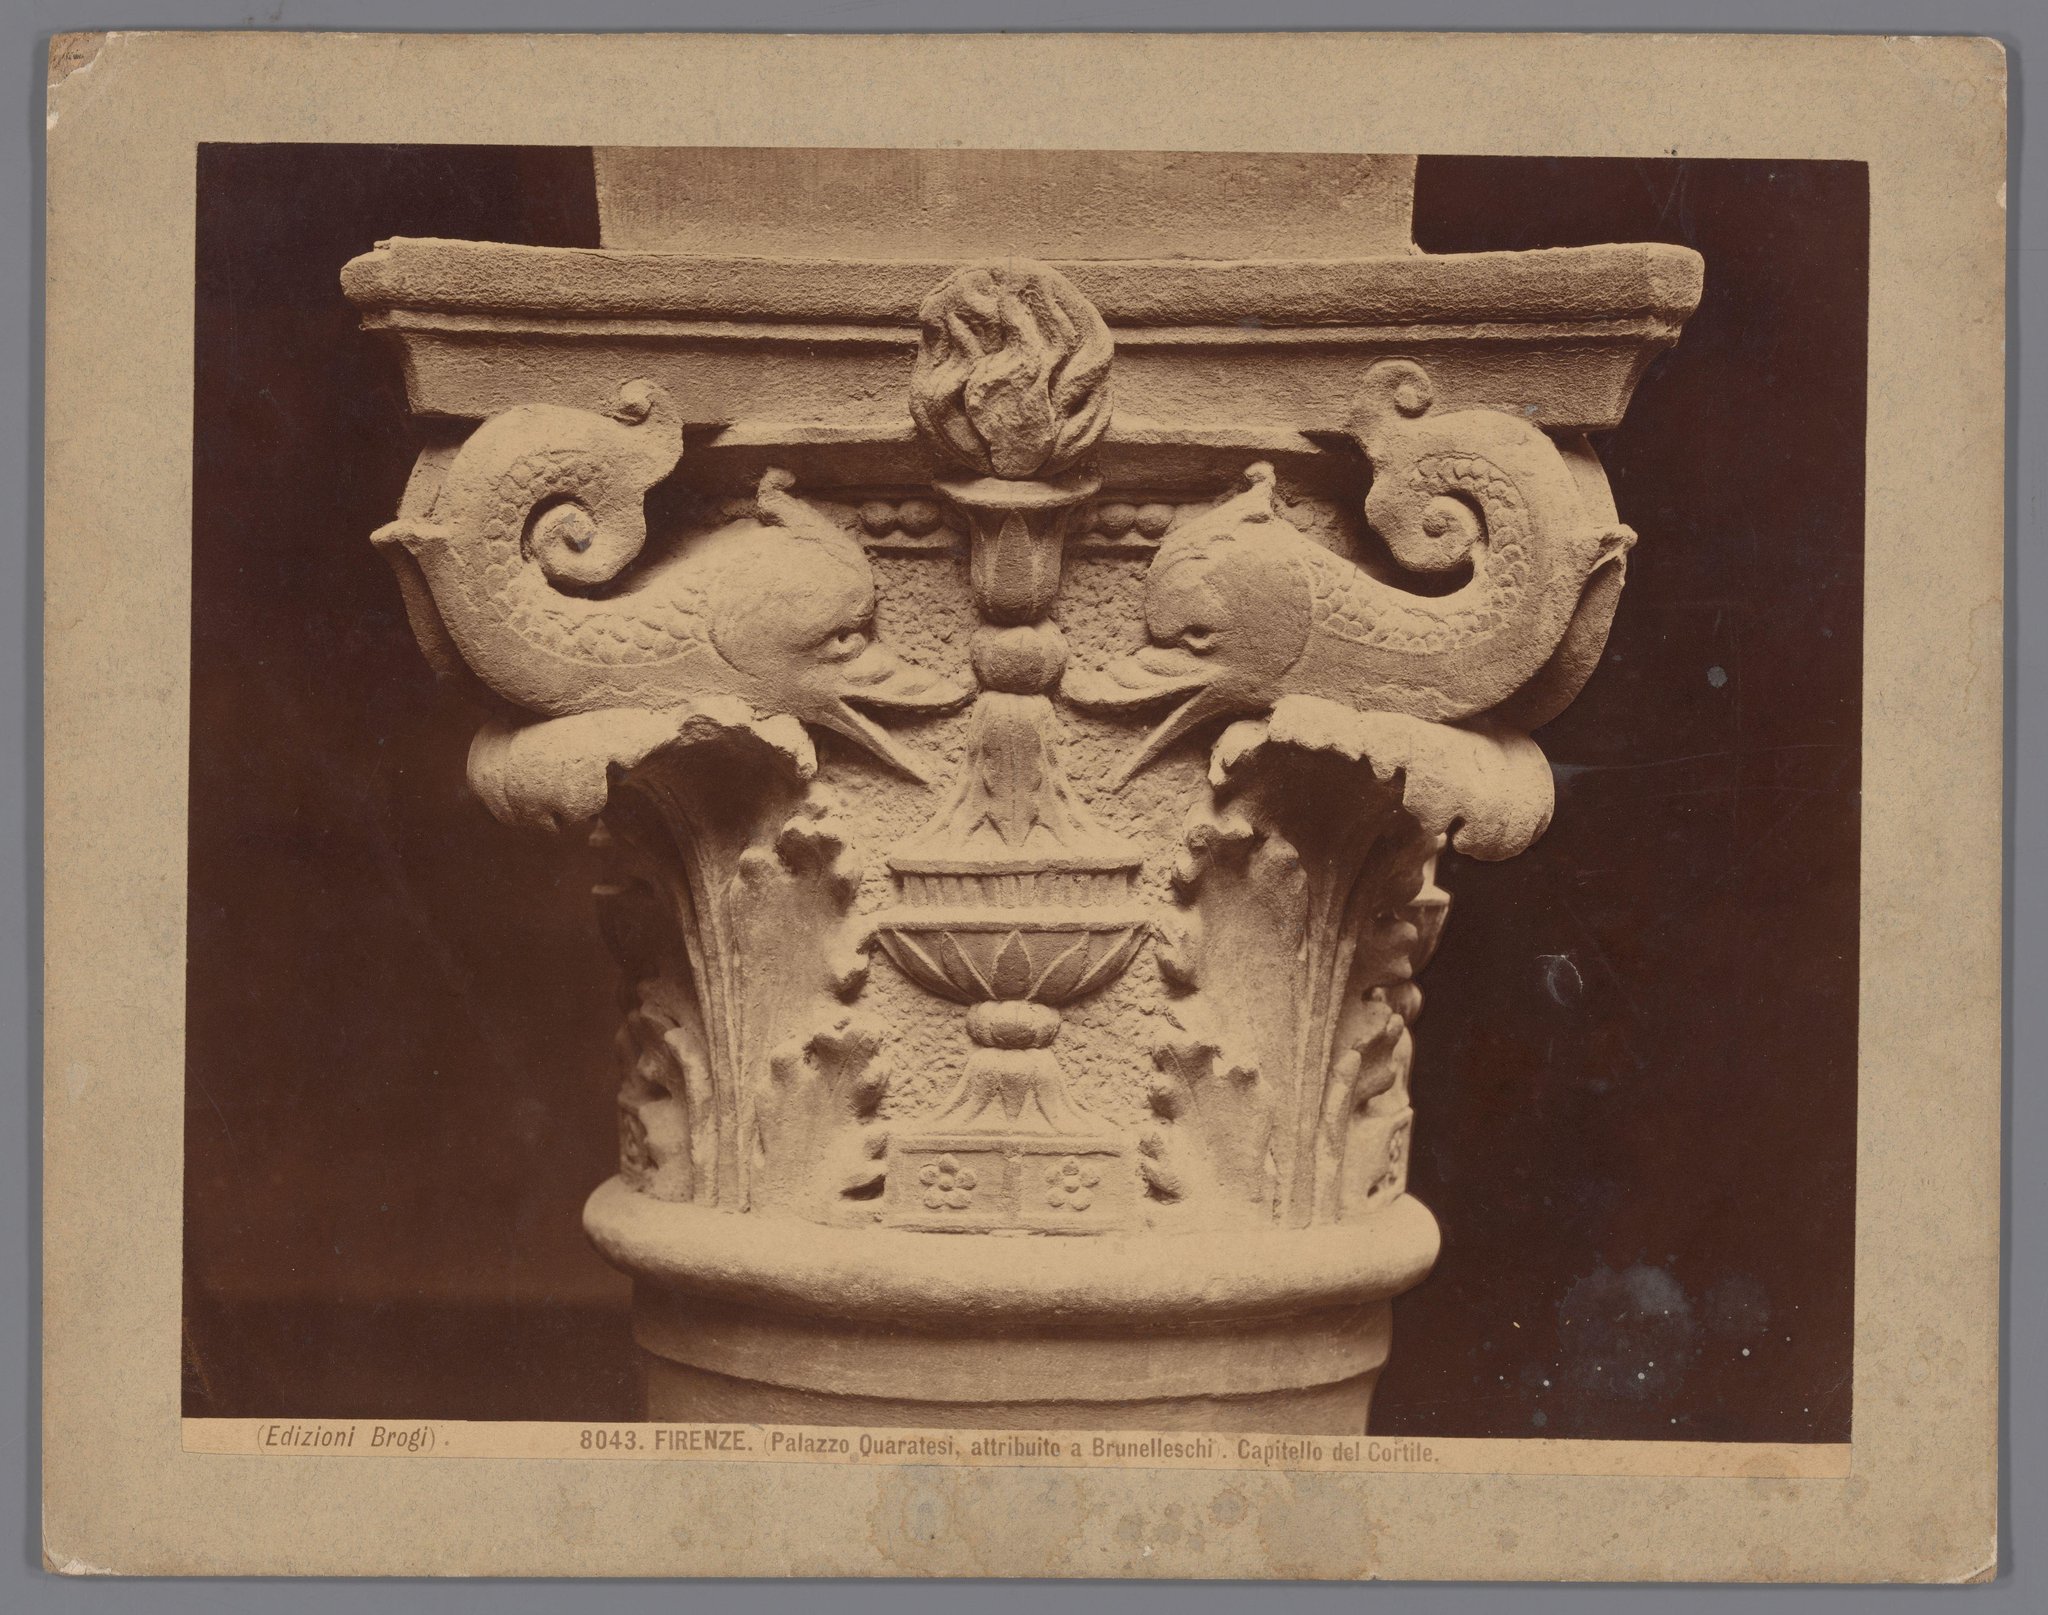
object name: photograph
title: Gedecoreerde kapiteel als bij Palazzo Pazzi te Florence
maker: Anonymous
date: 1850-1900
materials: cardboard, photographic support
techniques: albumen print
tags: capital (~ column, pillar)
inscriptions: collector's mark: ‘rijks school voor kunstnijverheid/ groep’, number: ‘8043’, inscription: ‘(Edizioni Brogi) (Palazzo Quaratesi, attribuito a Brunelleschi)’